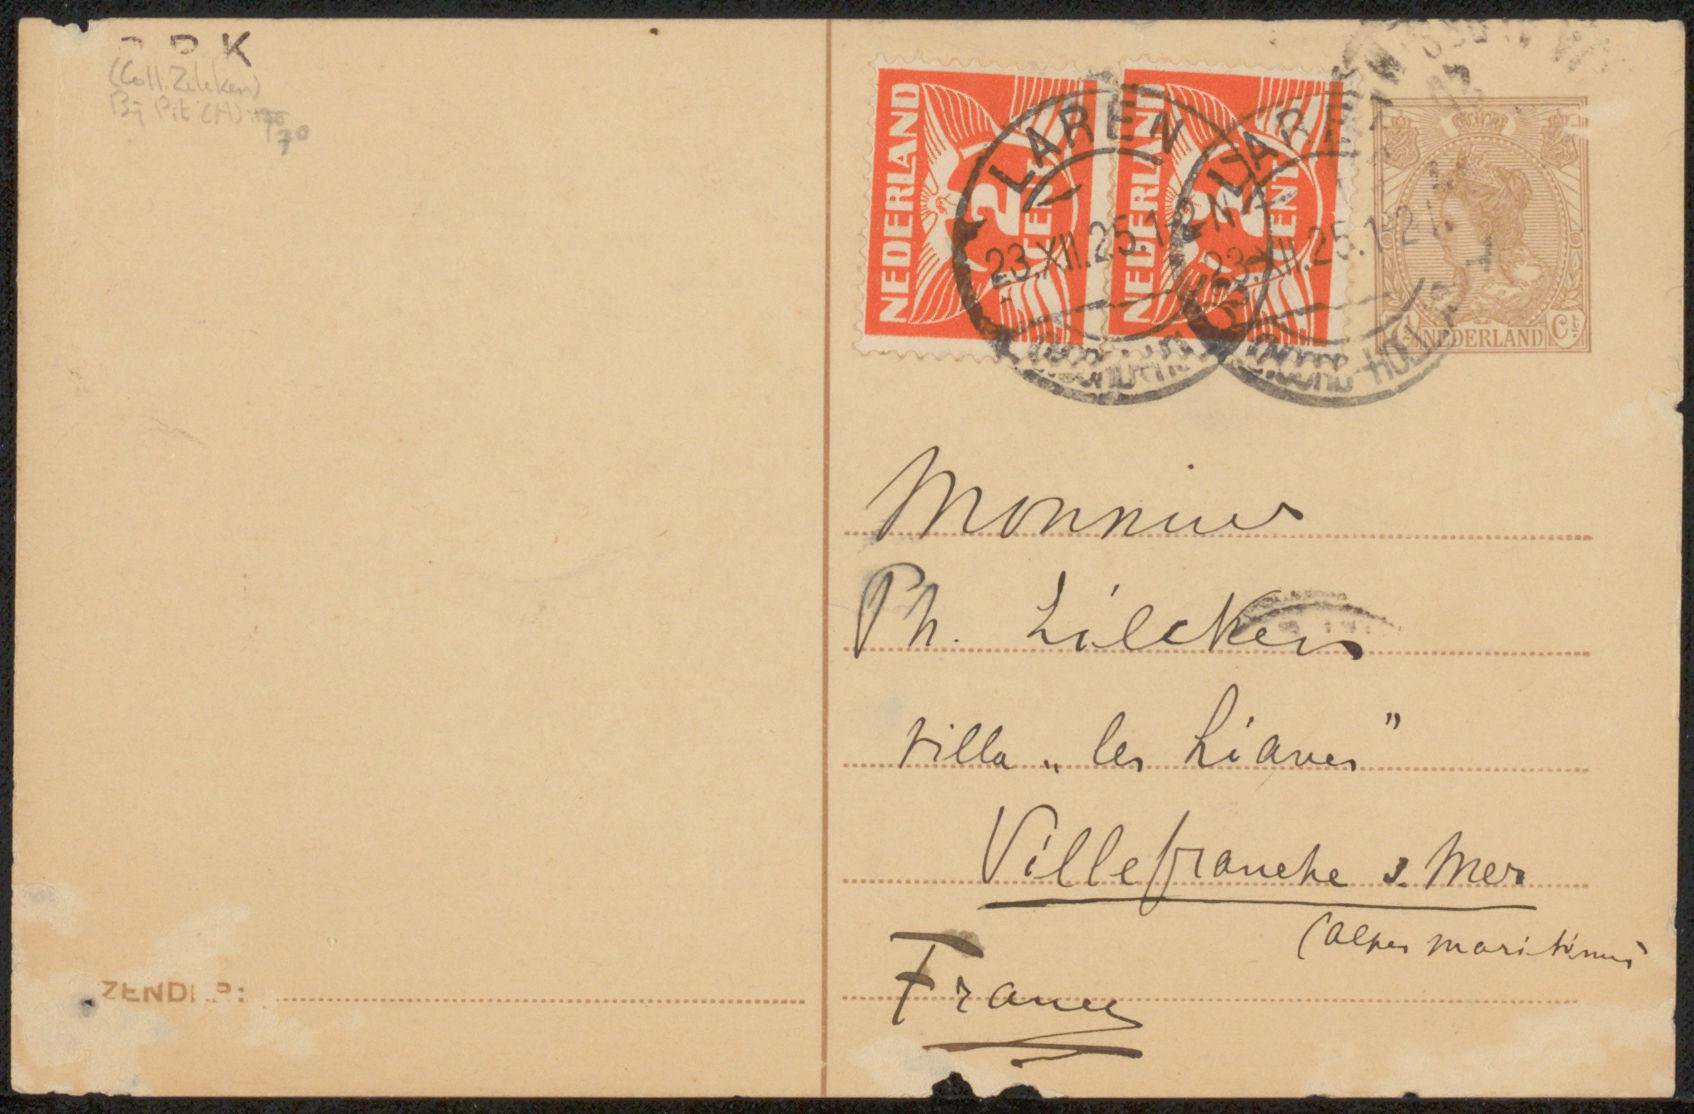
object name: postcard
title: Briefkaart aan Philip Zilcken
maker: adriaan pit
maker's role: print maker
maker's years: 1860-1944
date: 1925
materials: cardboard, ink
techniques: pen, writing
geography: laren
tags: the hague, painter, draughtsman, philip zilcken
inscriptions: collector's mark: ‘RPK’